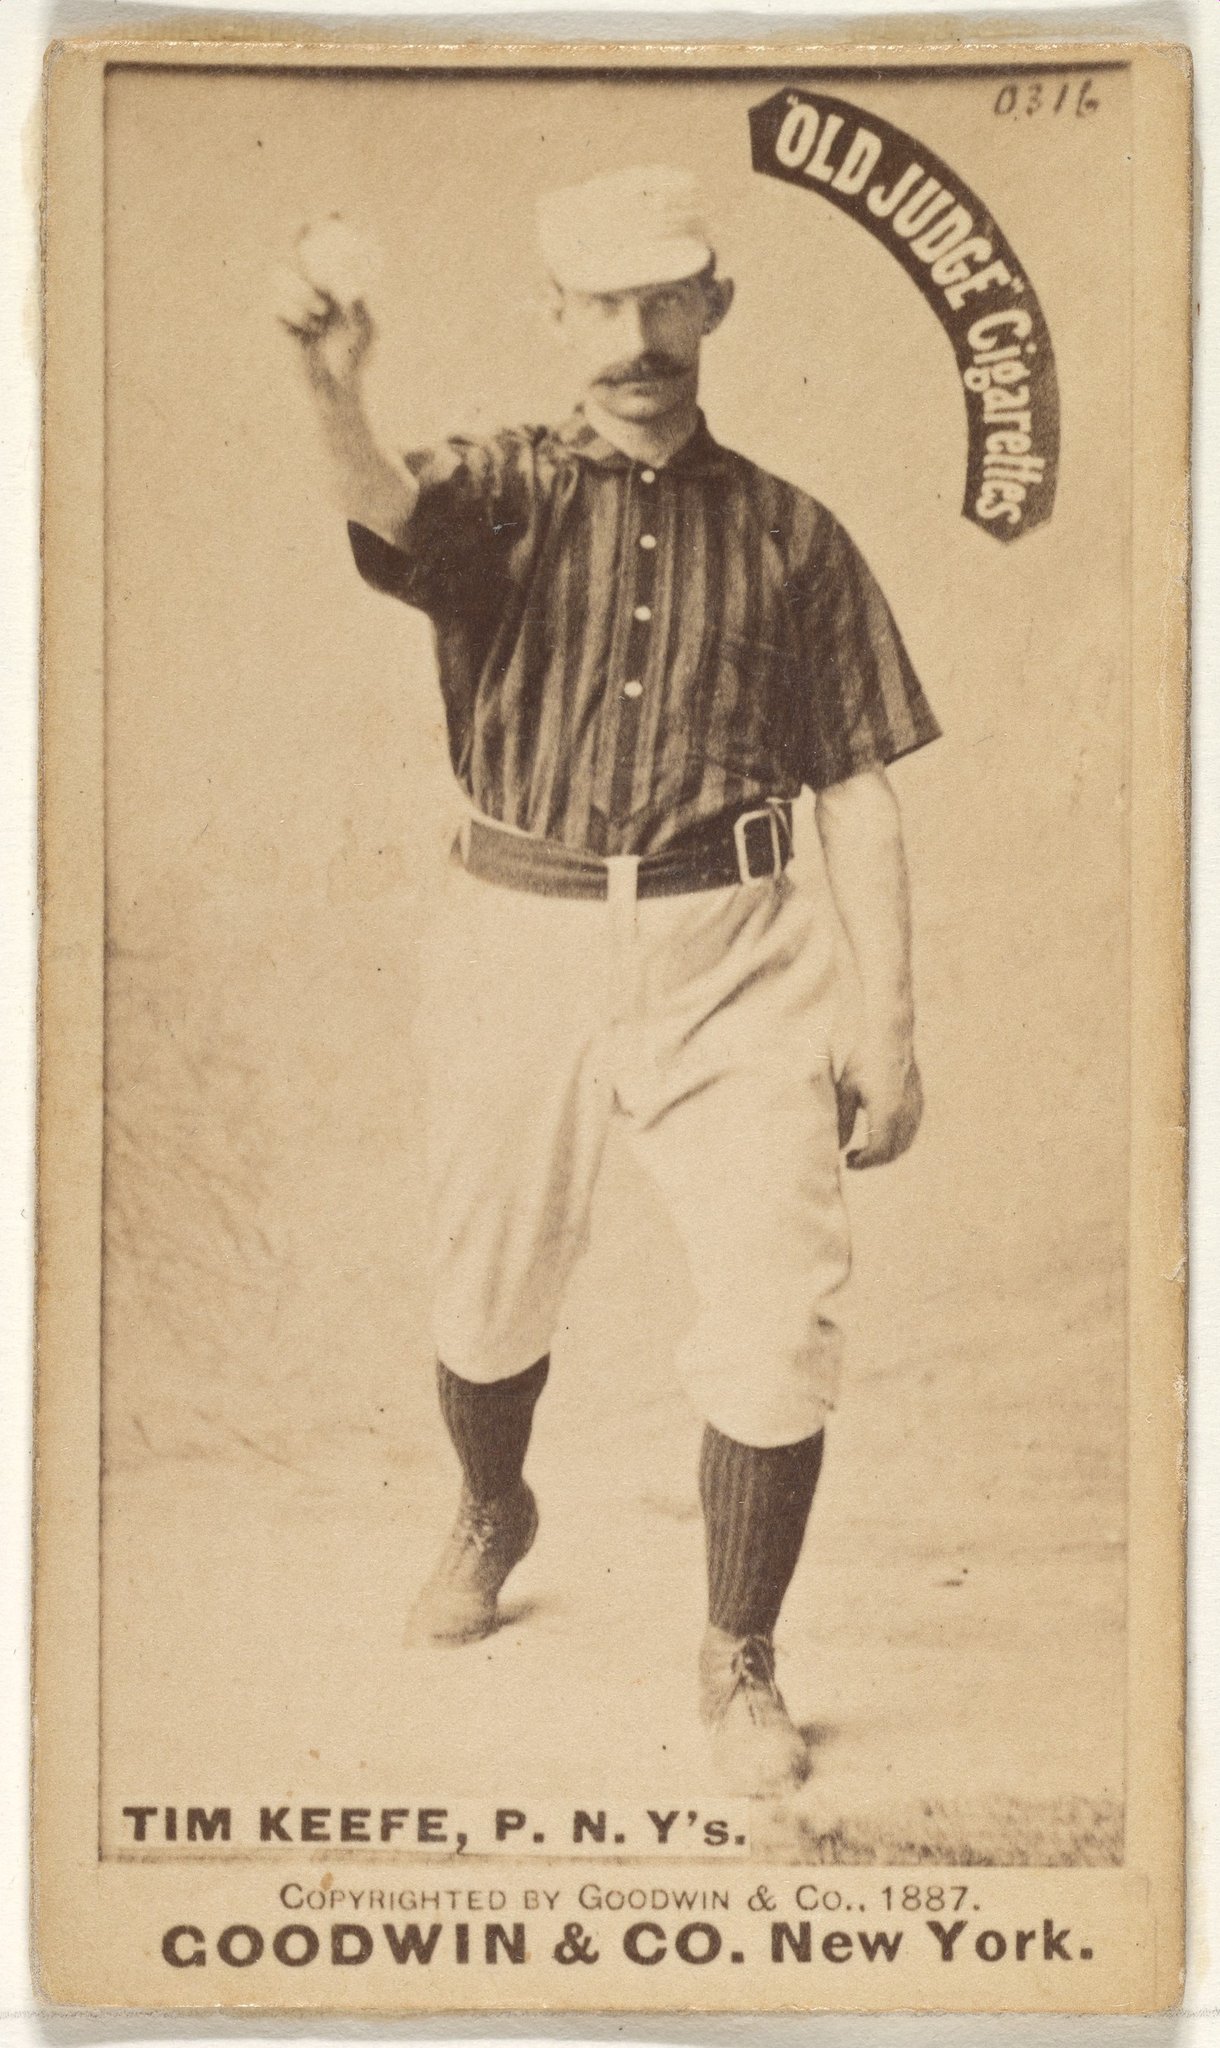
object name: baseball card, photograph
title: Timothy John "Tim" Keefe, Pitcher, New York, from the Old Judge series (N172) for Old Judge Cigarettes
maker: goodwin & company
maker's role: publisher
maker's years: 1850-1950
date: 1887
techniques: albumen silver print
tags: men,portraits,baseball,athletes